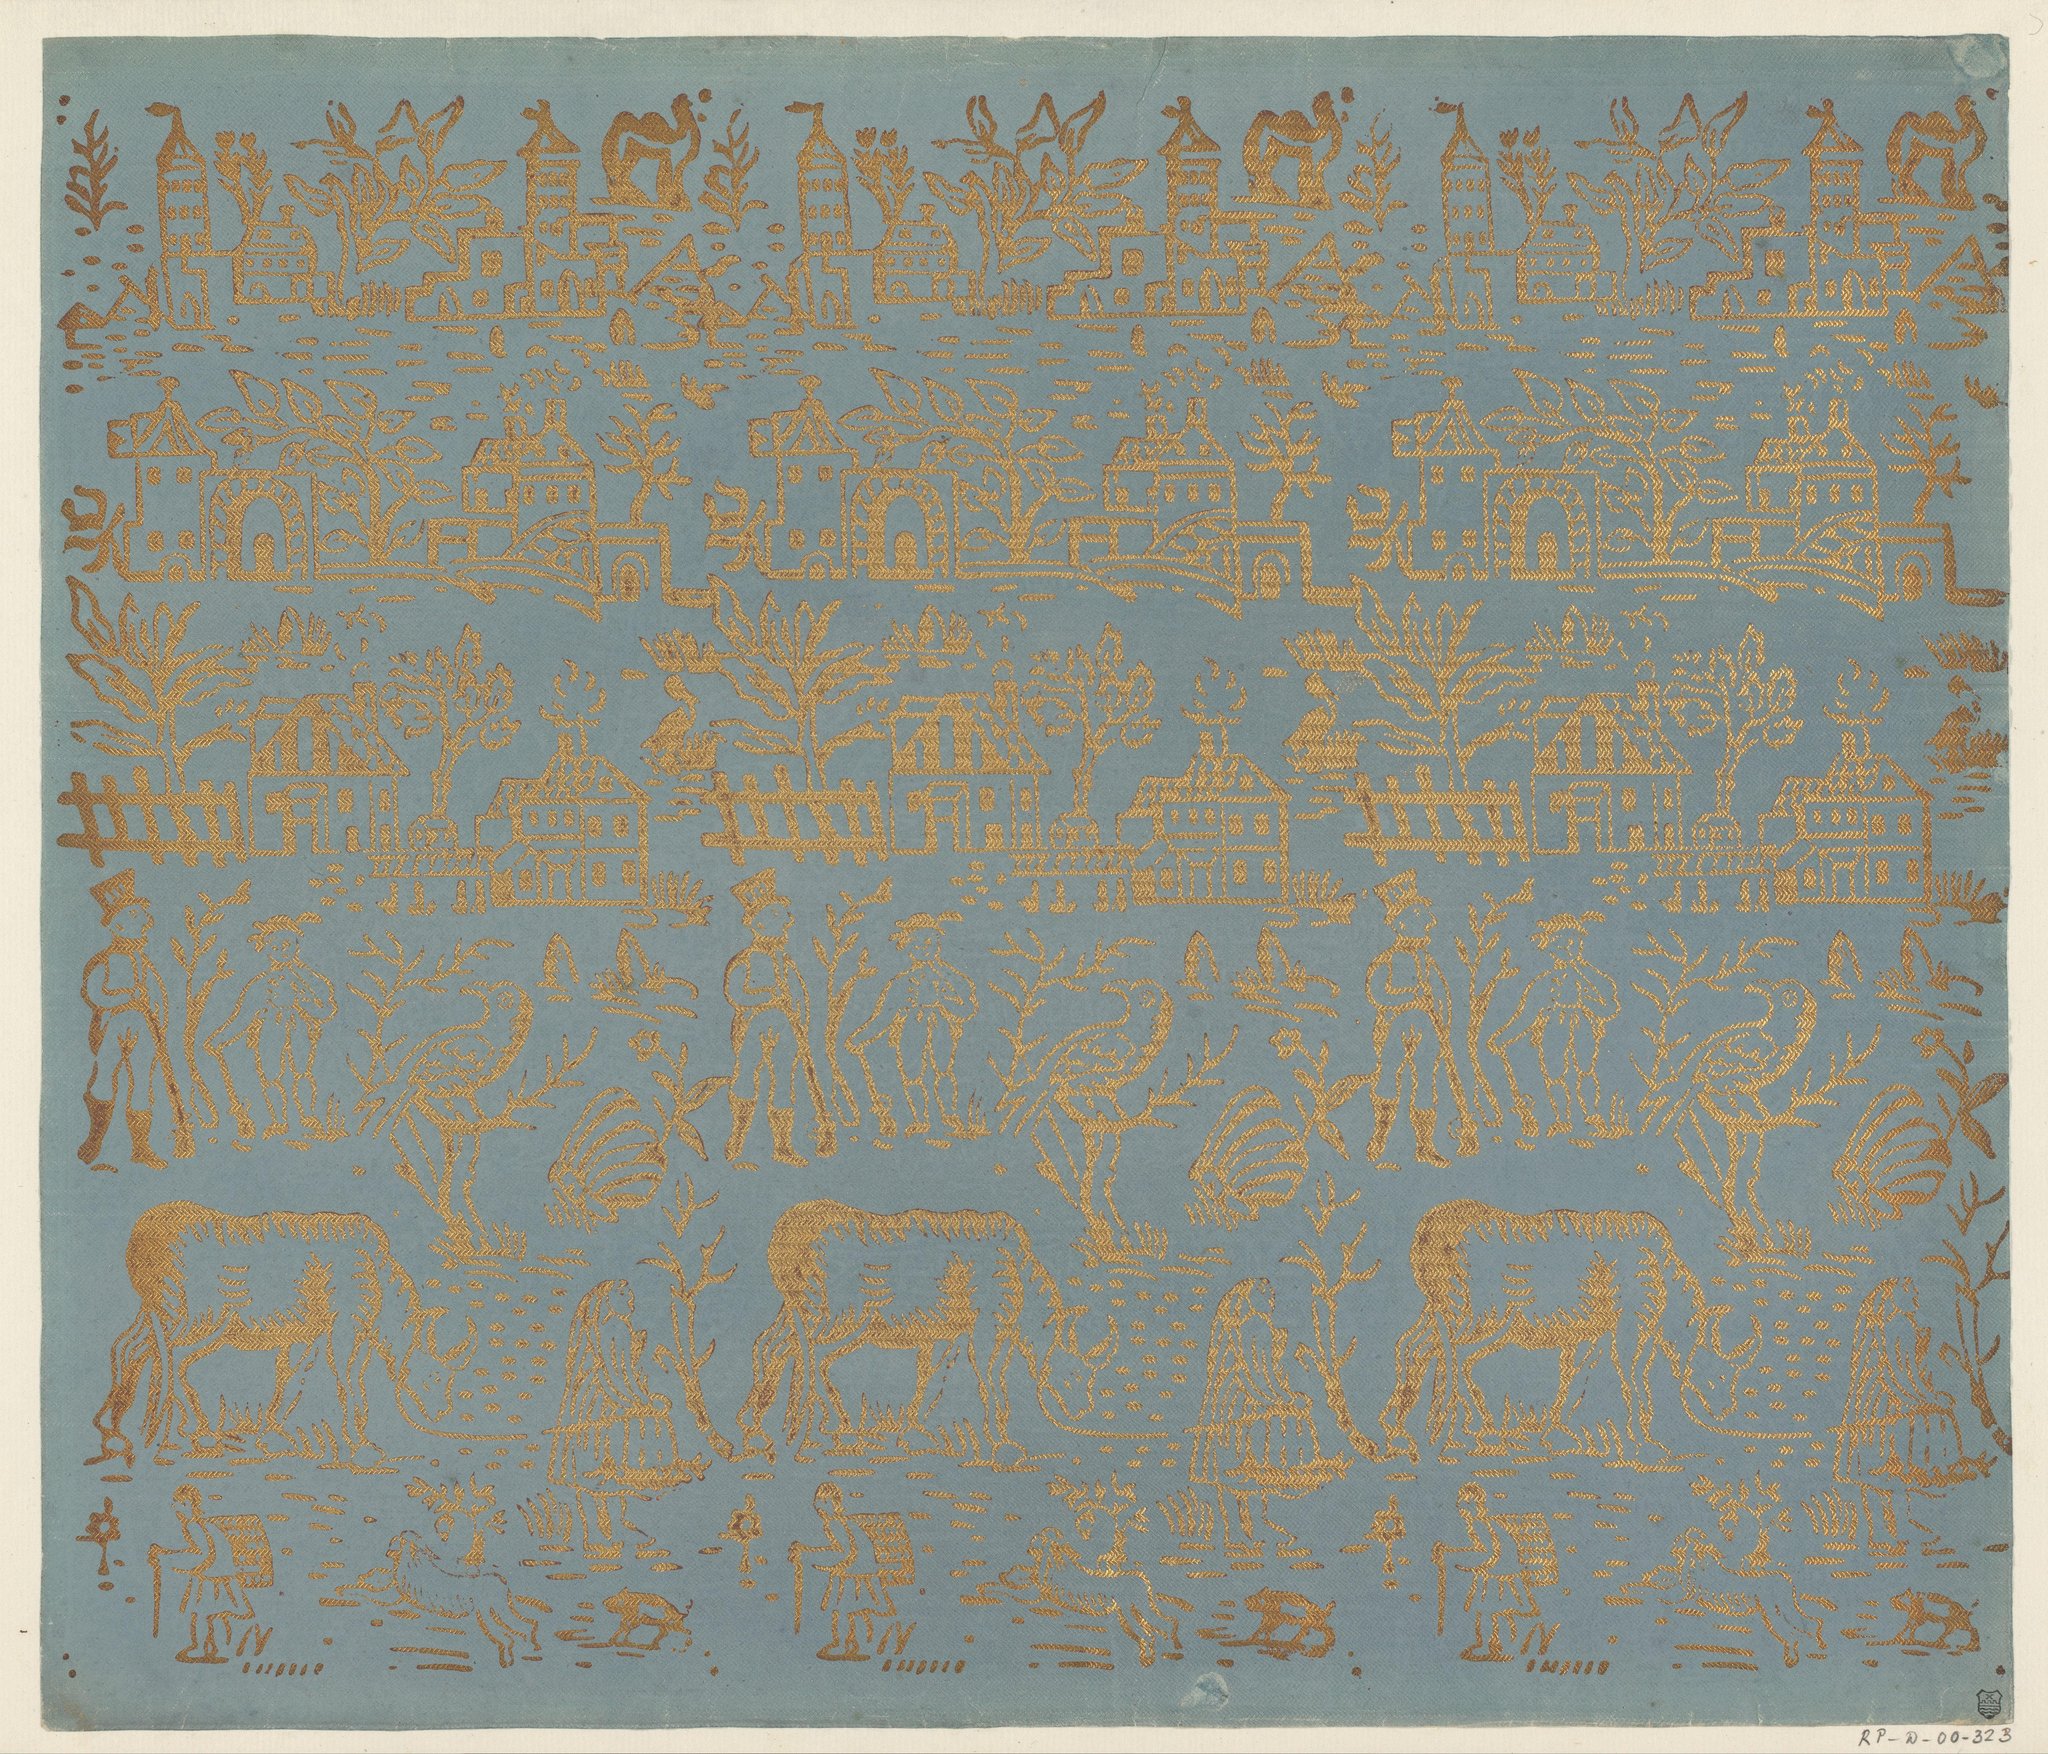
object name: brocade paper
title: Blad met dieren, mensen en huizen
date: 1850-1920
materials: gold leaf, paint, paper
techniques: machining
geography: aschaffenburg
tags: mammals, farmers, prospect of city, town panorama, silhouette of city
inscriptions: collector's mark: Lugt 2760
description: Blad met dieren, mensen en huizen, linksboven huis, rechtsboven kameel, linksonder bloem en marskramer, rechtsonder staand dier.